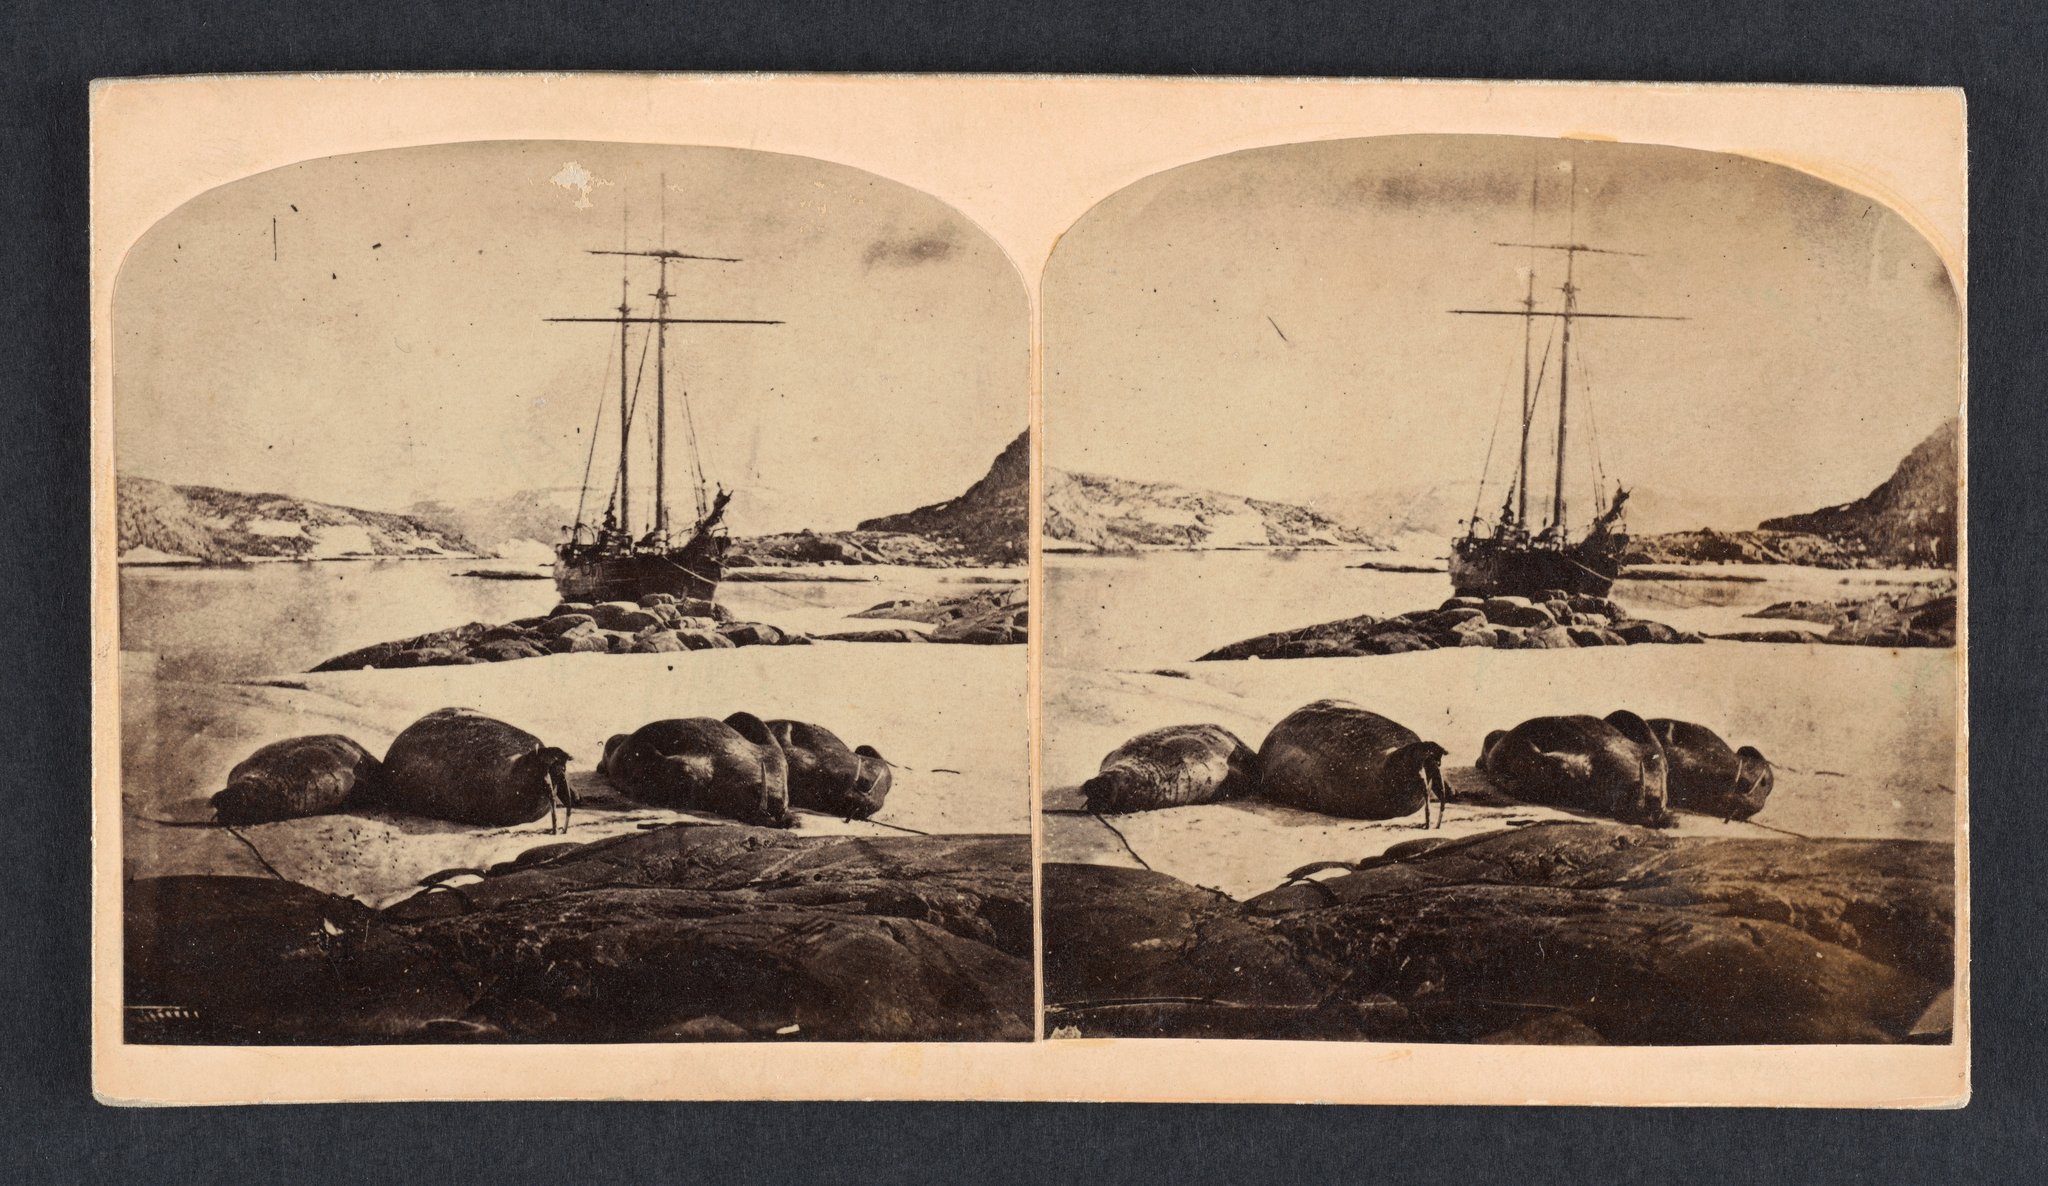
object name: stereograph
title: Scène de la mer glacial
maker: isaac israel hayes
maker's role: artist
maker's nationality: american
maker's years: 1832-1881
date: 1859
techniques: albumen silver print, glass negative